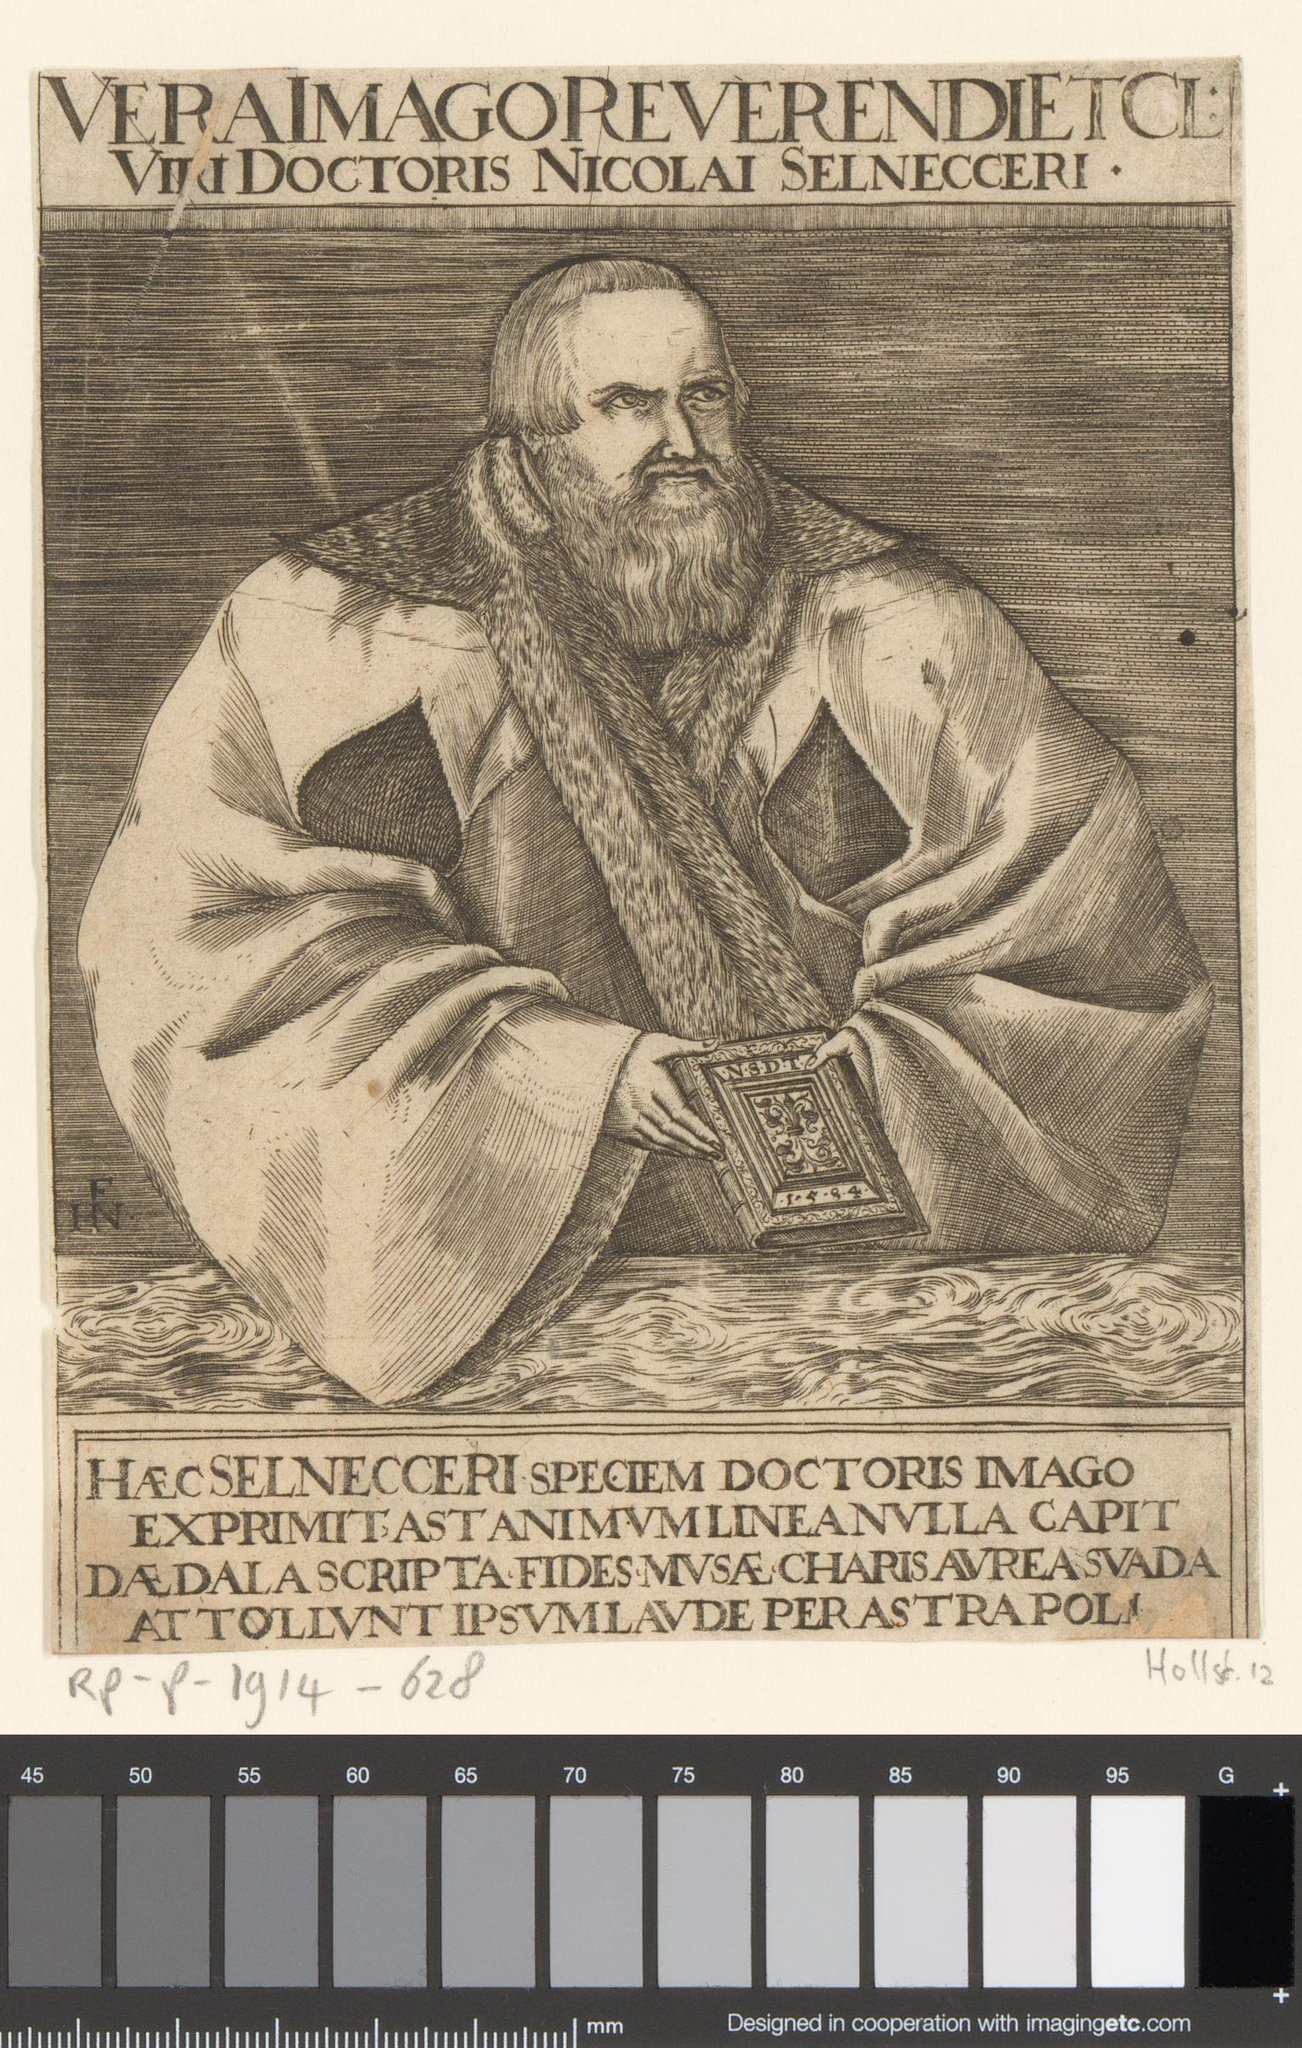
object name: print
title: Portret van Nikolaus Selnecker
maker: hieronymus nützel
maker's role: print maker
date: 1584-1591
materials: paper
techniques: engraving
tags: historical persons, book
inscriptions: collector's mark: Lugt 2228